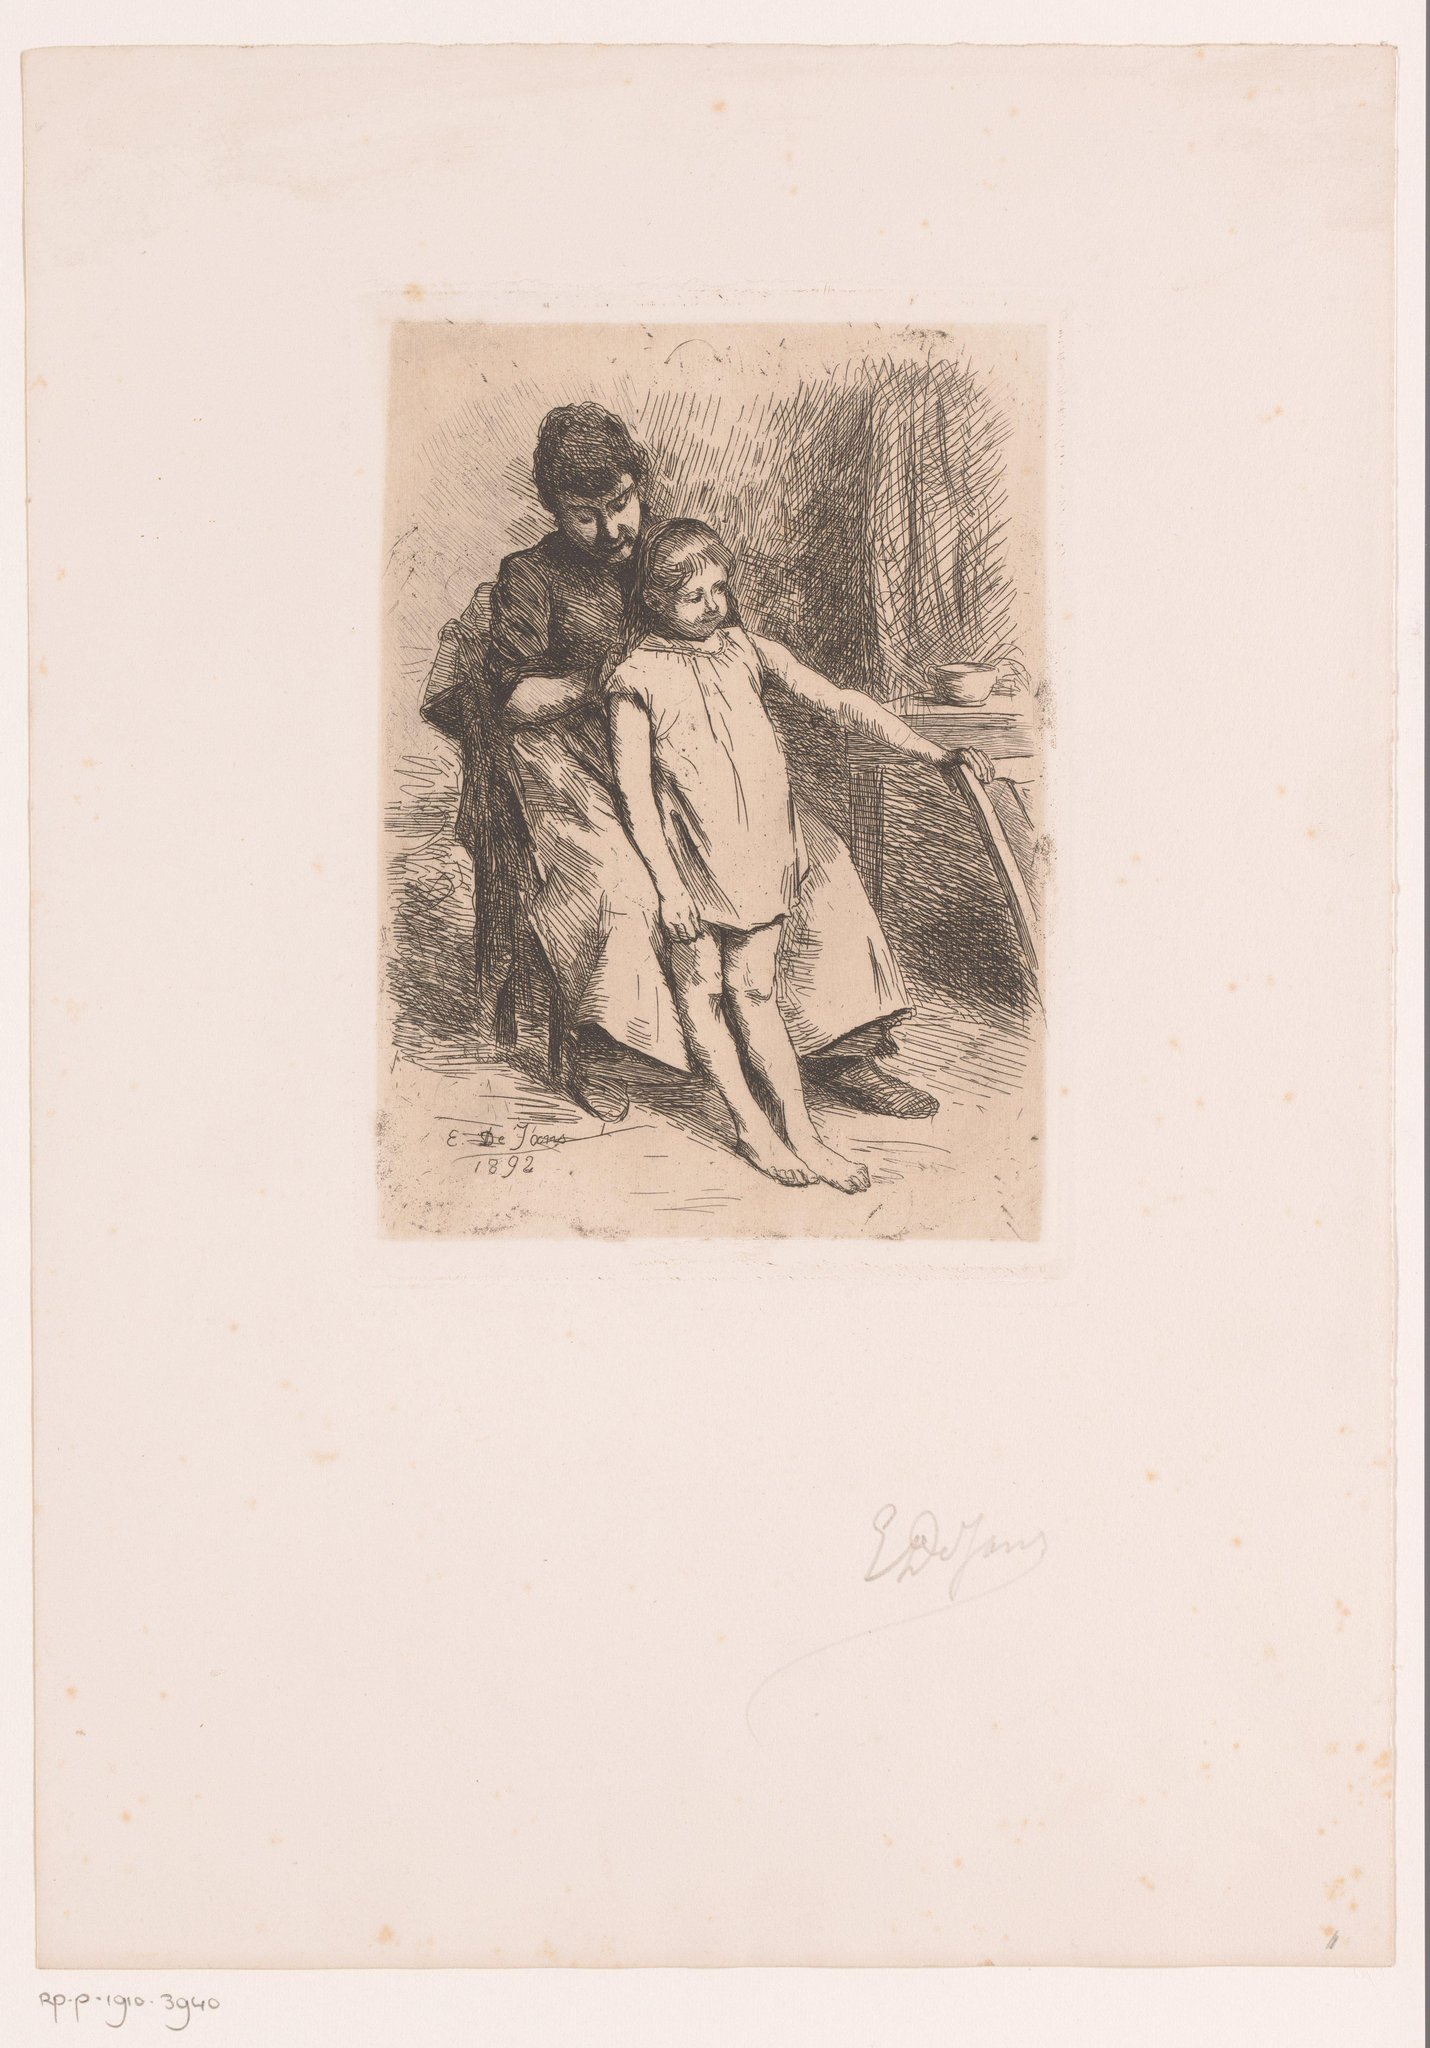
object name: print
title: Moeder met kind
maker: edouard de jans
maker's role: print maker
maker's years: 1855-1919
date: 1892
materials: paper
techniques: etching, intaglio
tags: mother and baby or young child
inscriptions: collector's mark: Lugt 2228